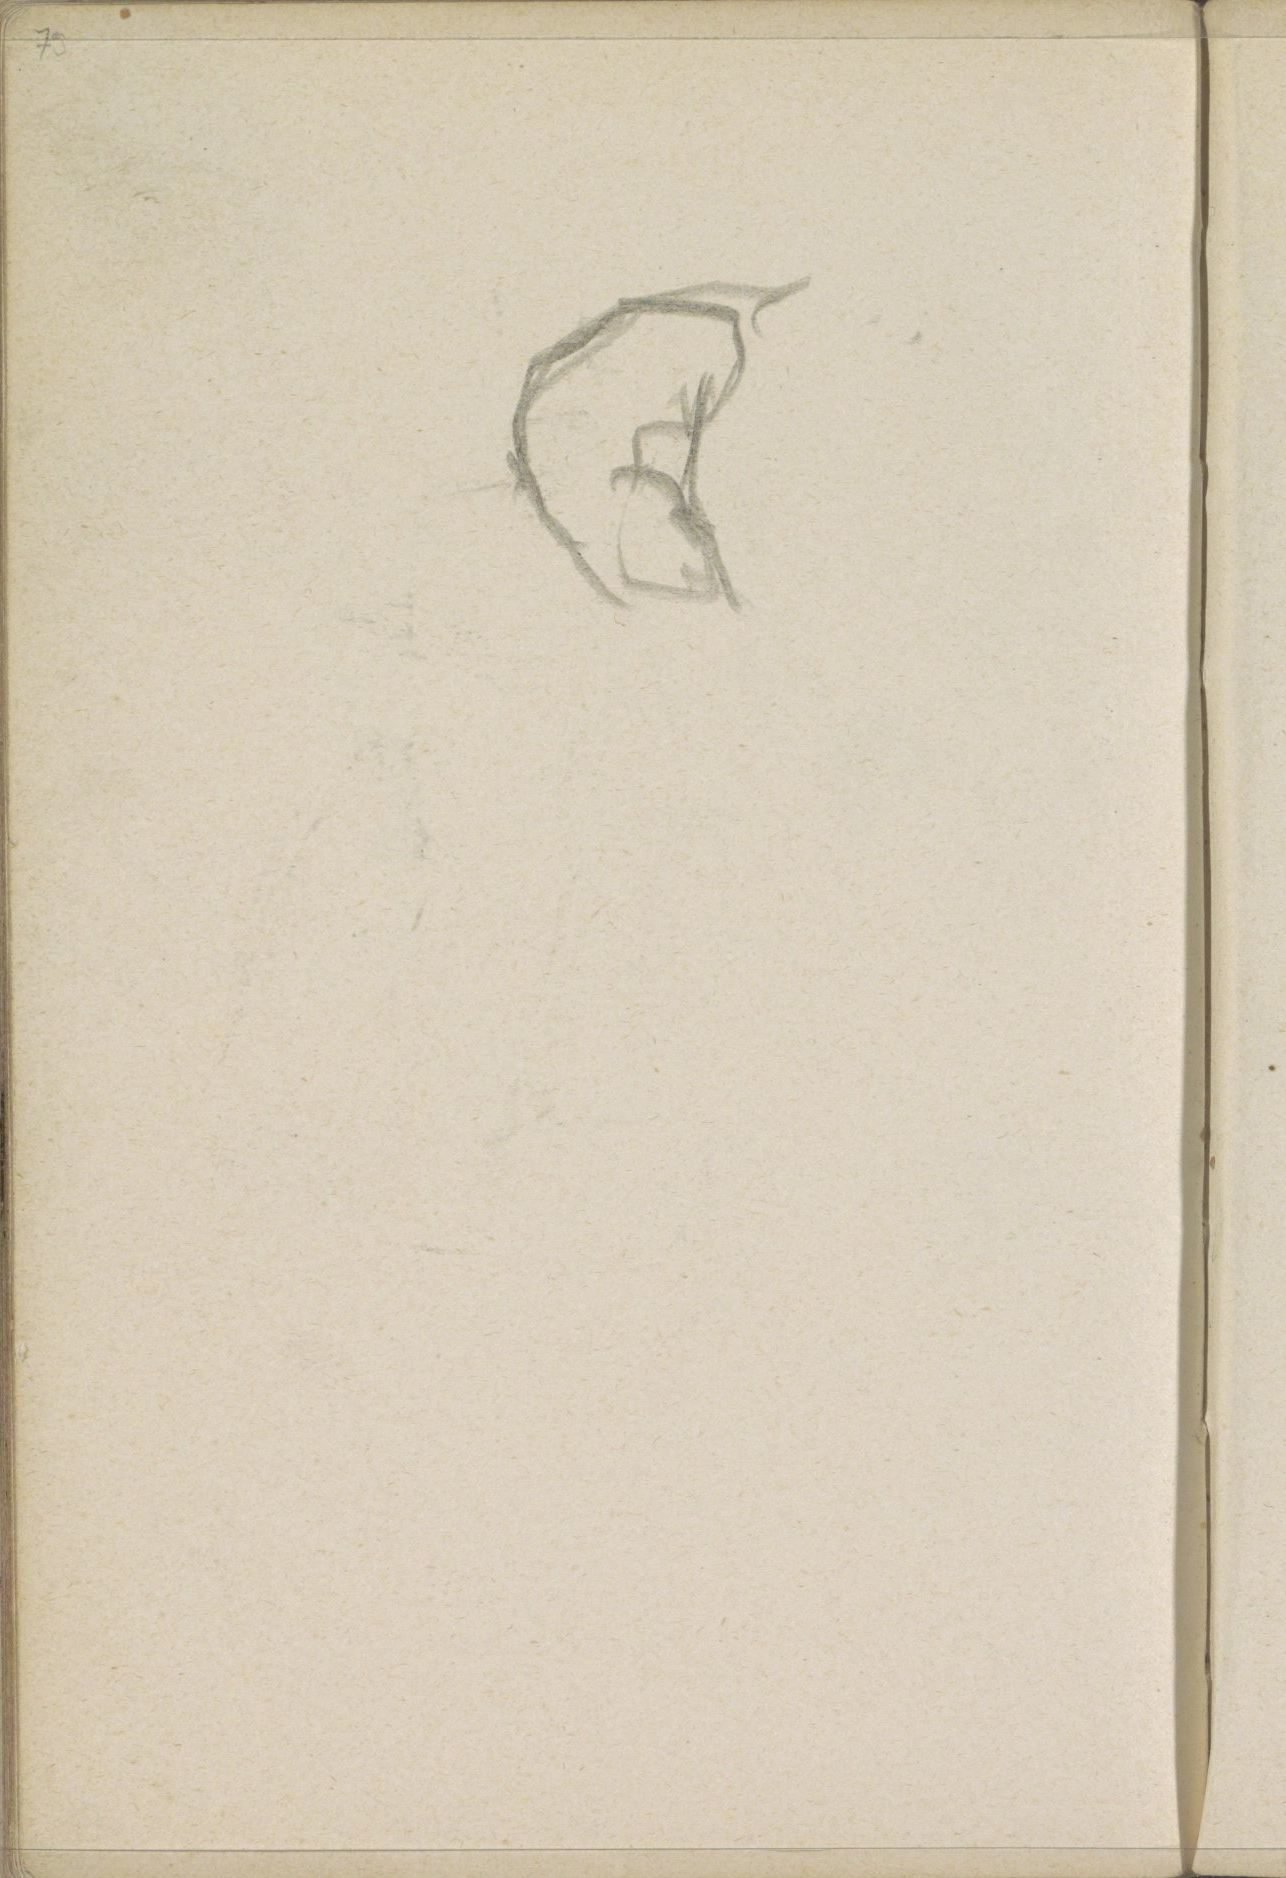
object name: sketchbook leaf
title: Studie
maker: george hendrik breitner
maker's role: draughtsman, painter, print maker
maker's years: 1857-1923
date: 1900-1923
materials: paper, pencil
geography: amsterdam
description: Pagina 75 uit een schetsboek met 39 bladen.